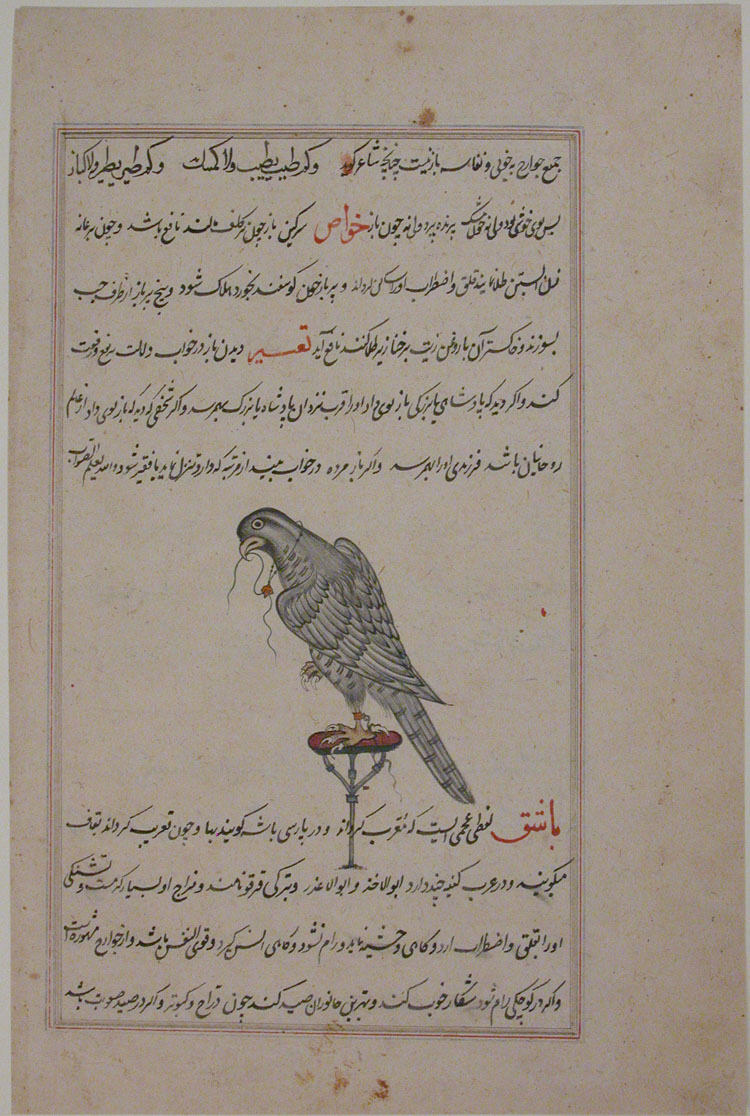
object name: folio from an illustrated manuscript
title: "Hawk on Perch", Folio from a Bestiary and Herbal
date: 1600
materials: gold, paper, watercolor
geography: iran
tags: hawks